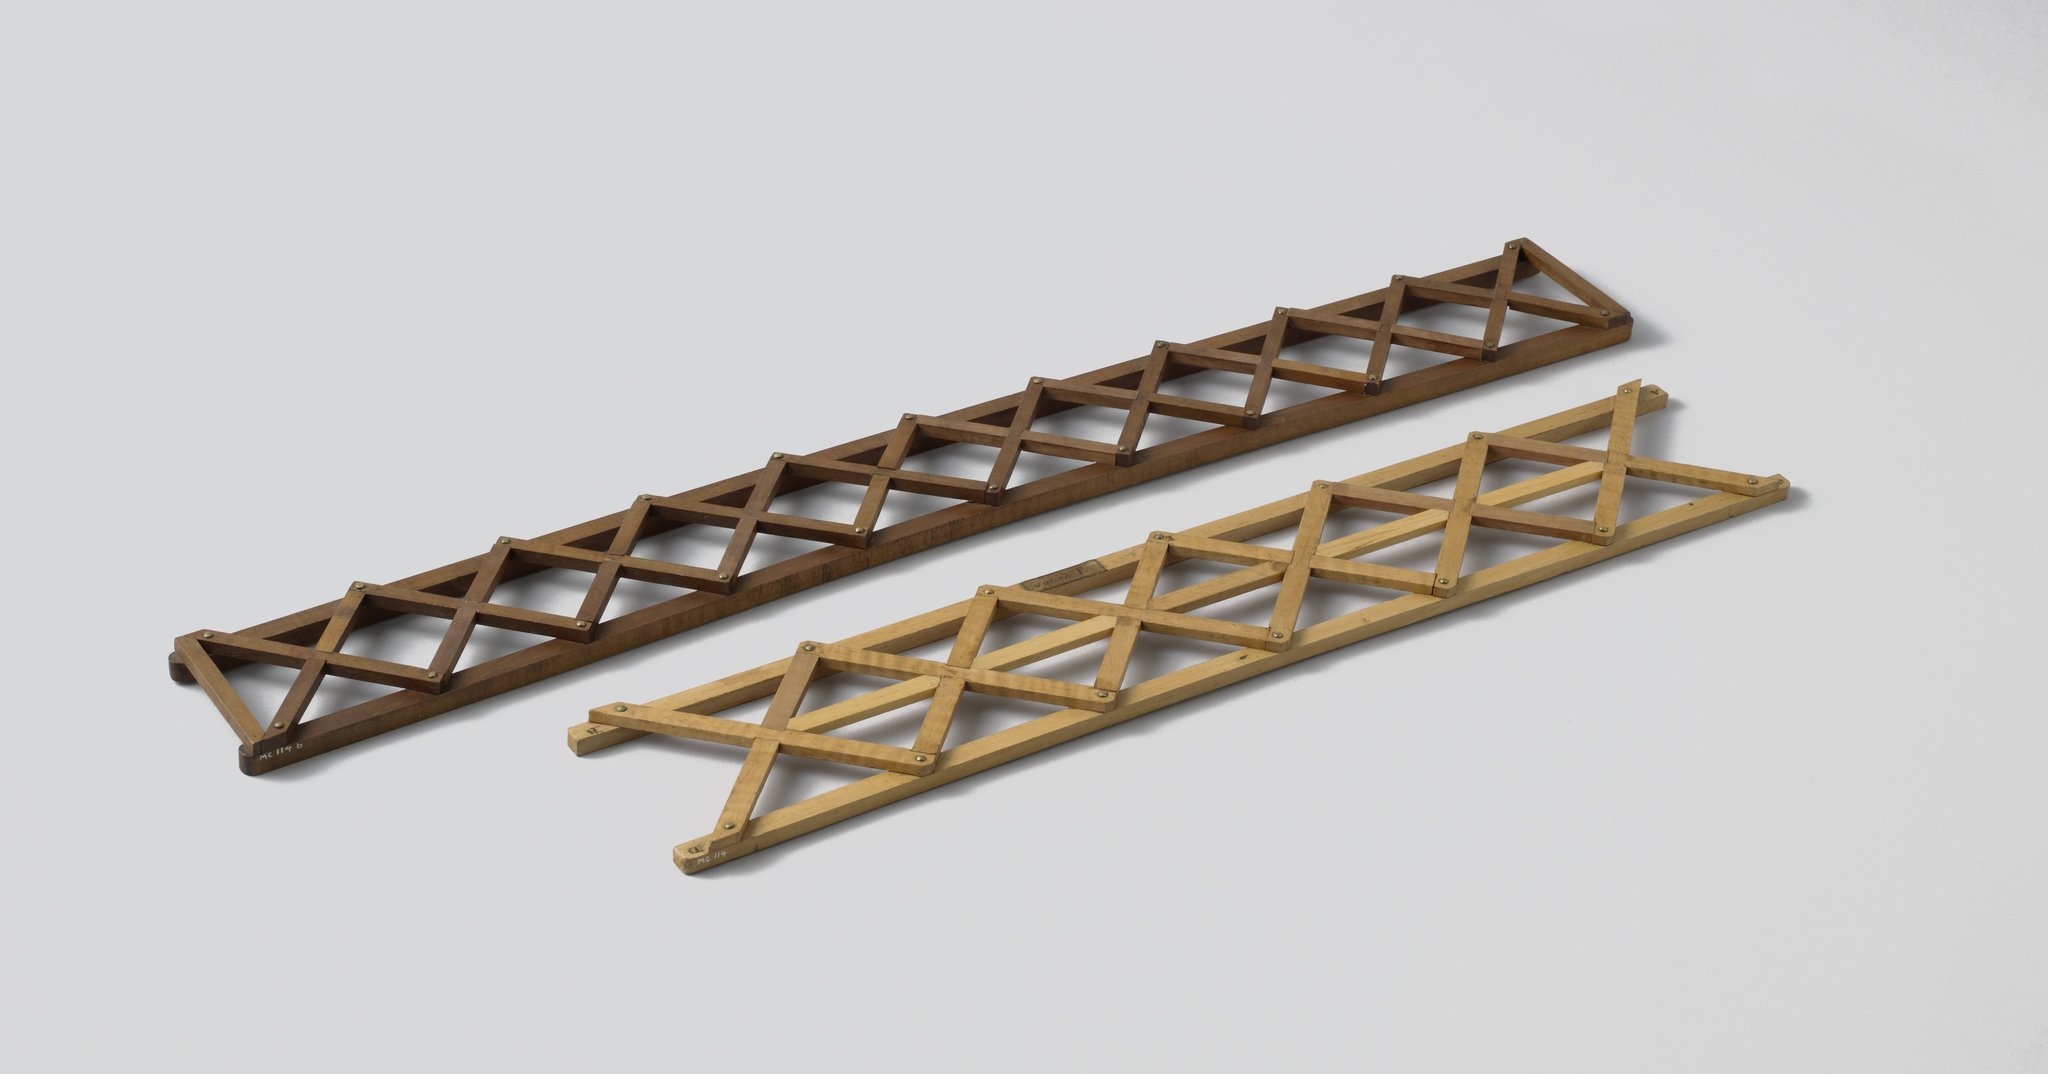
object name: instruction model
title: Two Models of Diagonal Framing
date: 1822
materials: brass, wood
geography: united kingdom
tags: england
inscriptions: inscription, on model B: parts are numbered 1 to 18, inscription, on model A: parts are marked A to E, inscription, on model A: ‘MODEL E’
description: Twee modellen die het kruisverband volgens Robert Seppings demonstreren. Ze bestaan uit twee wegerbalken, waartussen diagonale schoren, steunders en sleutels zijn aangebracht.